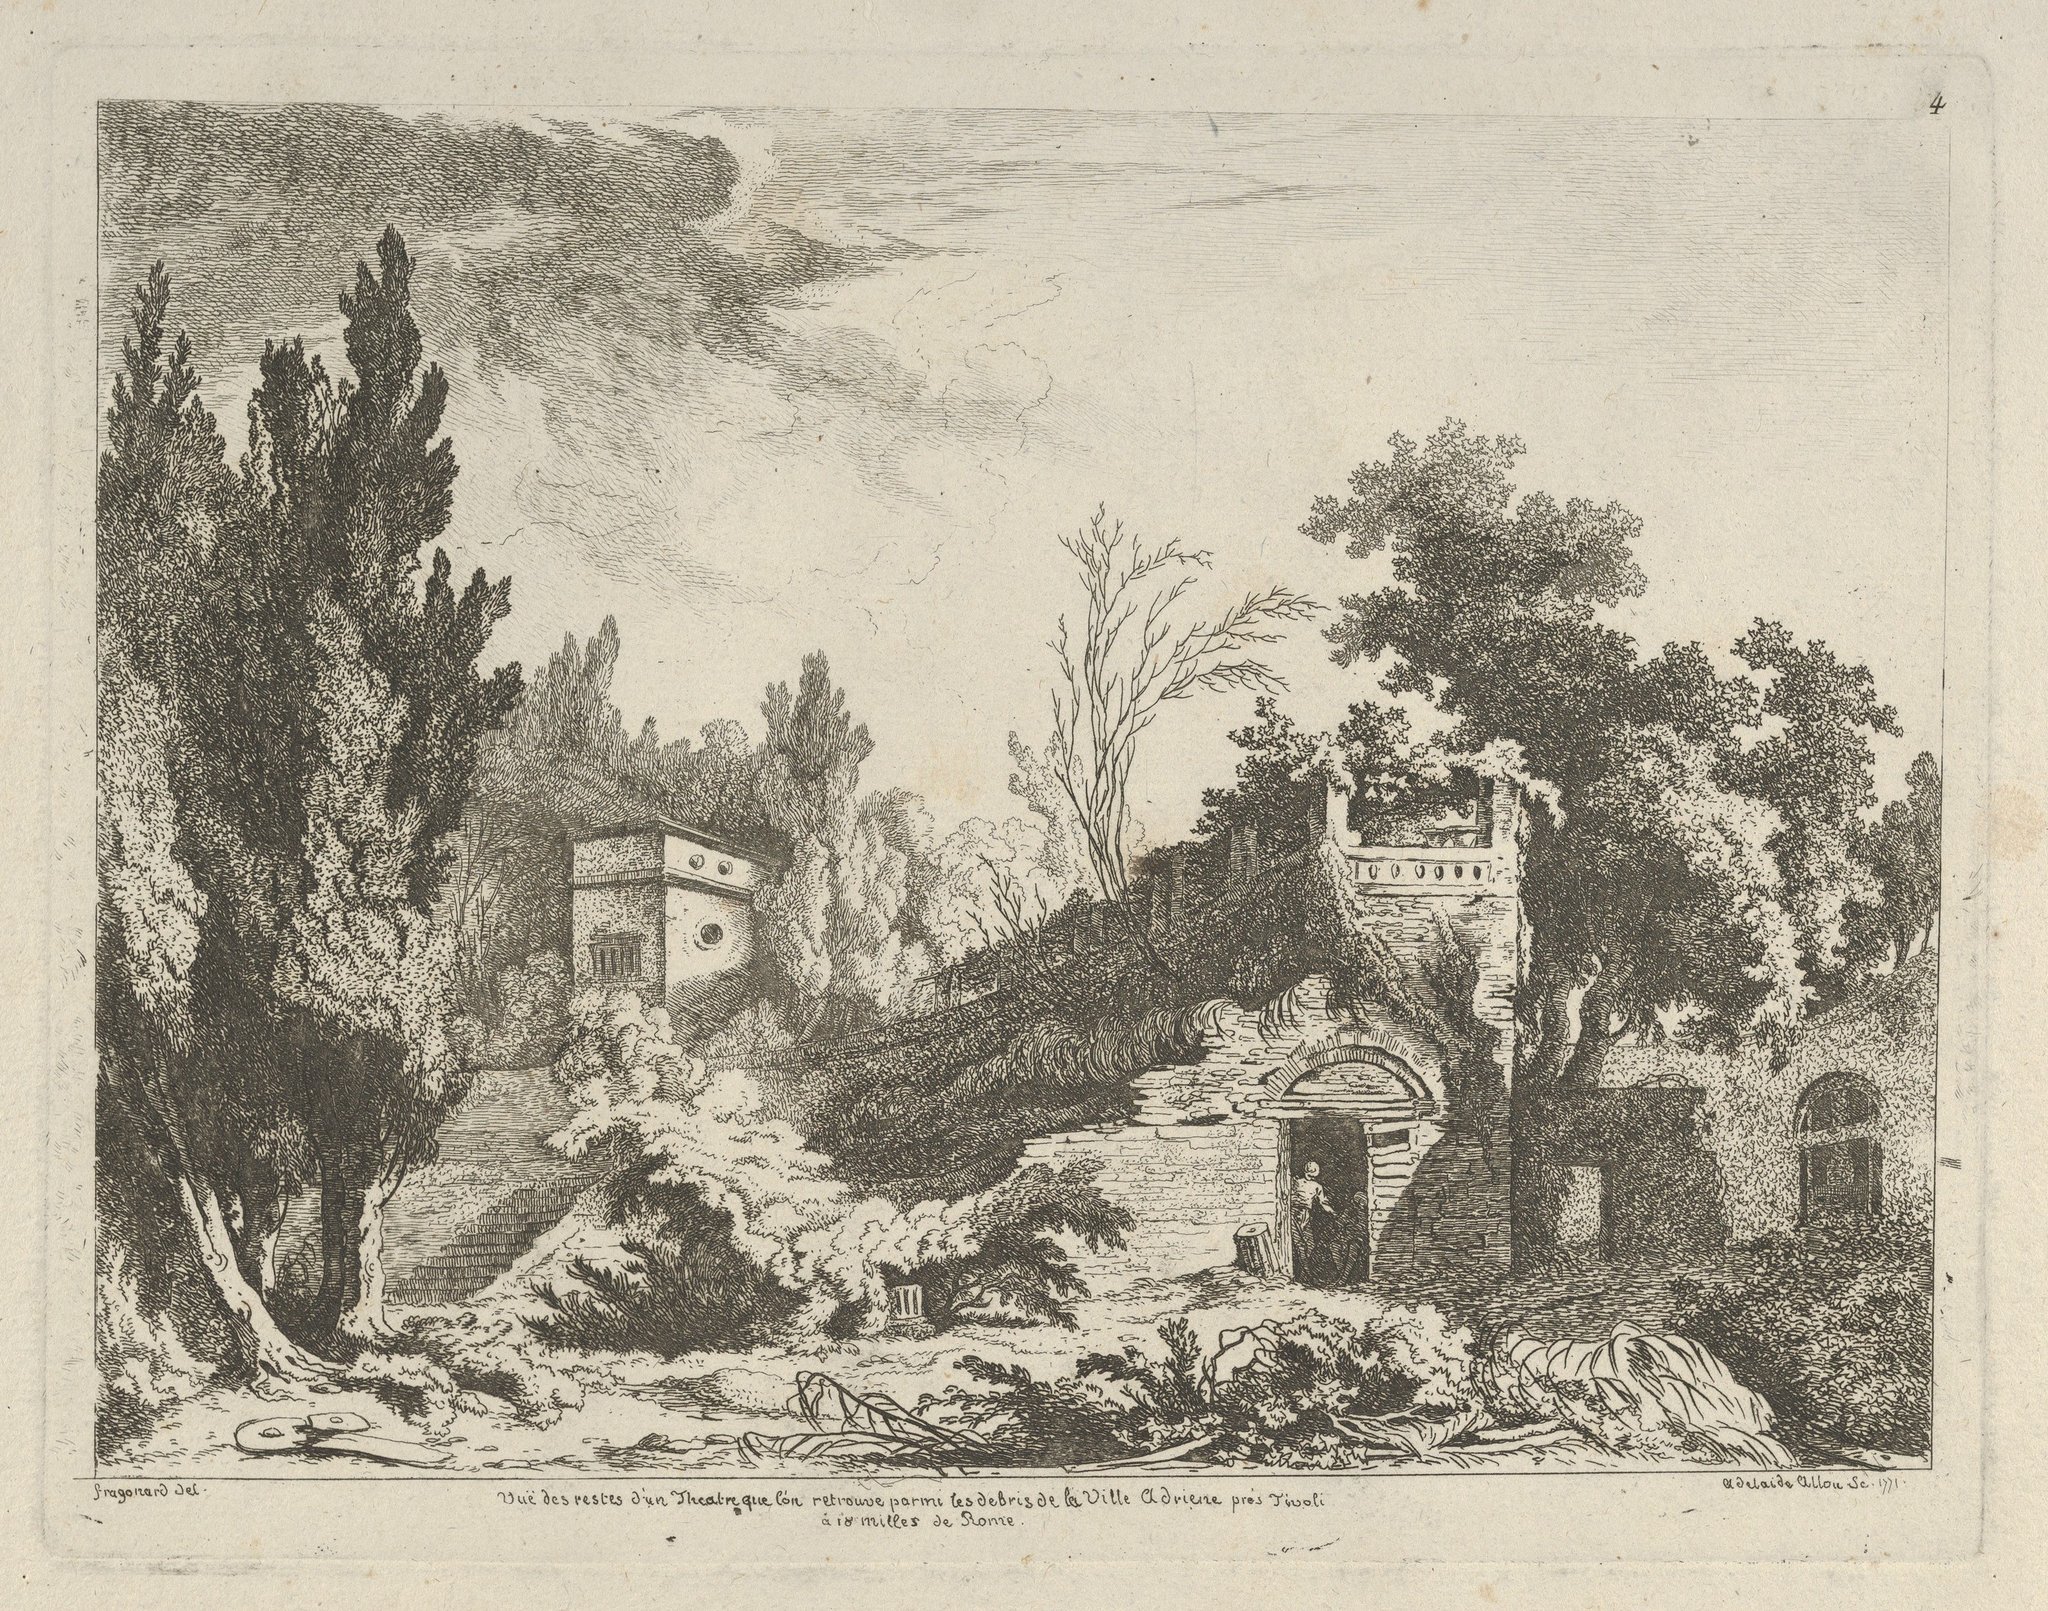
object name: print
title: Vue des restes d'un théâtre from Differentes vues dessiné d'après nature... dans les environs de Rome et de Naples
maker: adélaide allou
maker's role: artist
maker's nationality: french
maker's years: 1776-1800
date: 1701-1800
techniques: etching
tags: ruins,trees